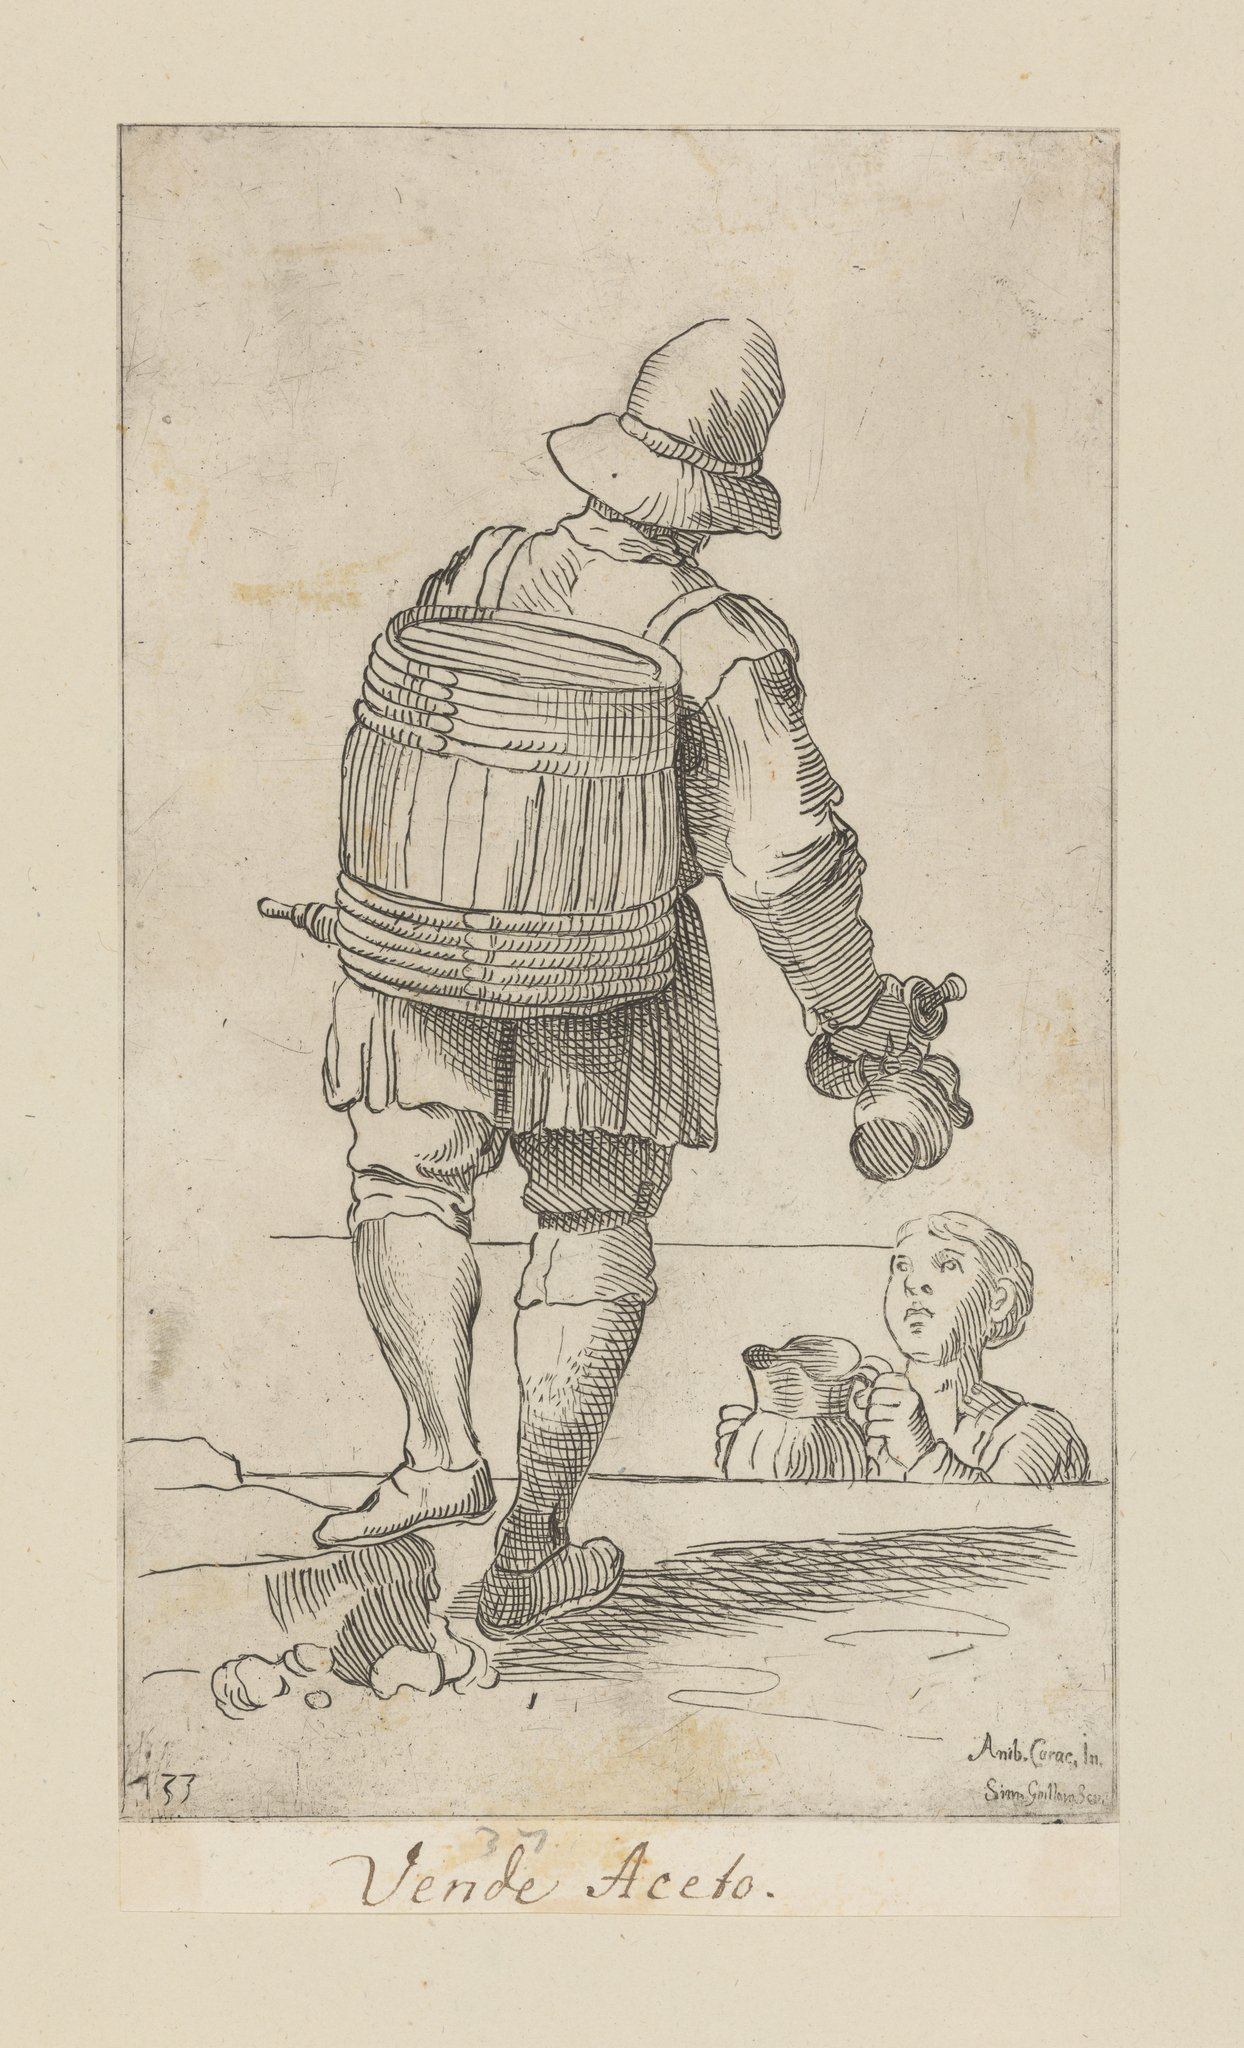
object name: print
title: Plate 33: Vinegar vendor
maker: simon guillain ii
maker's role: artist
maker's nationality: french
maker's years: 1618-1718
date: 1646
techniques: etching